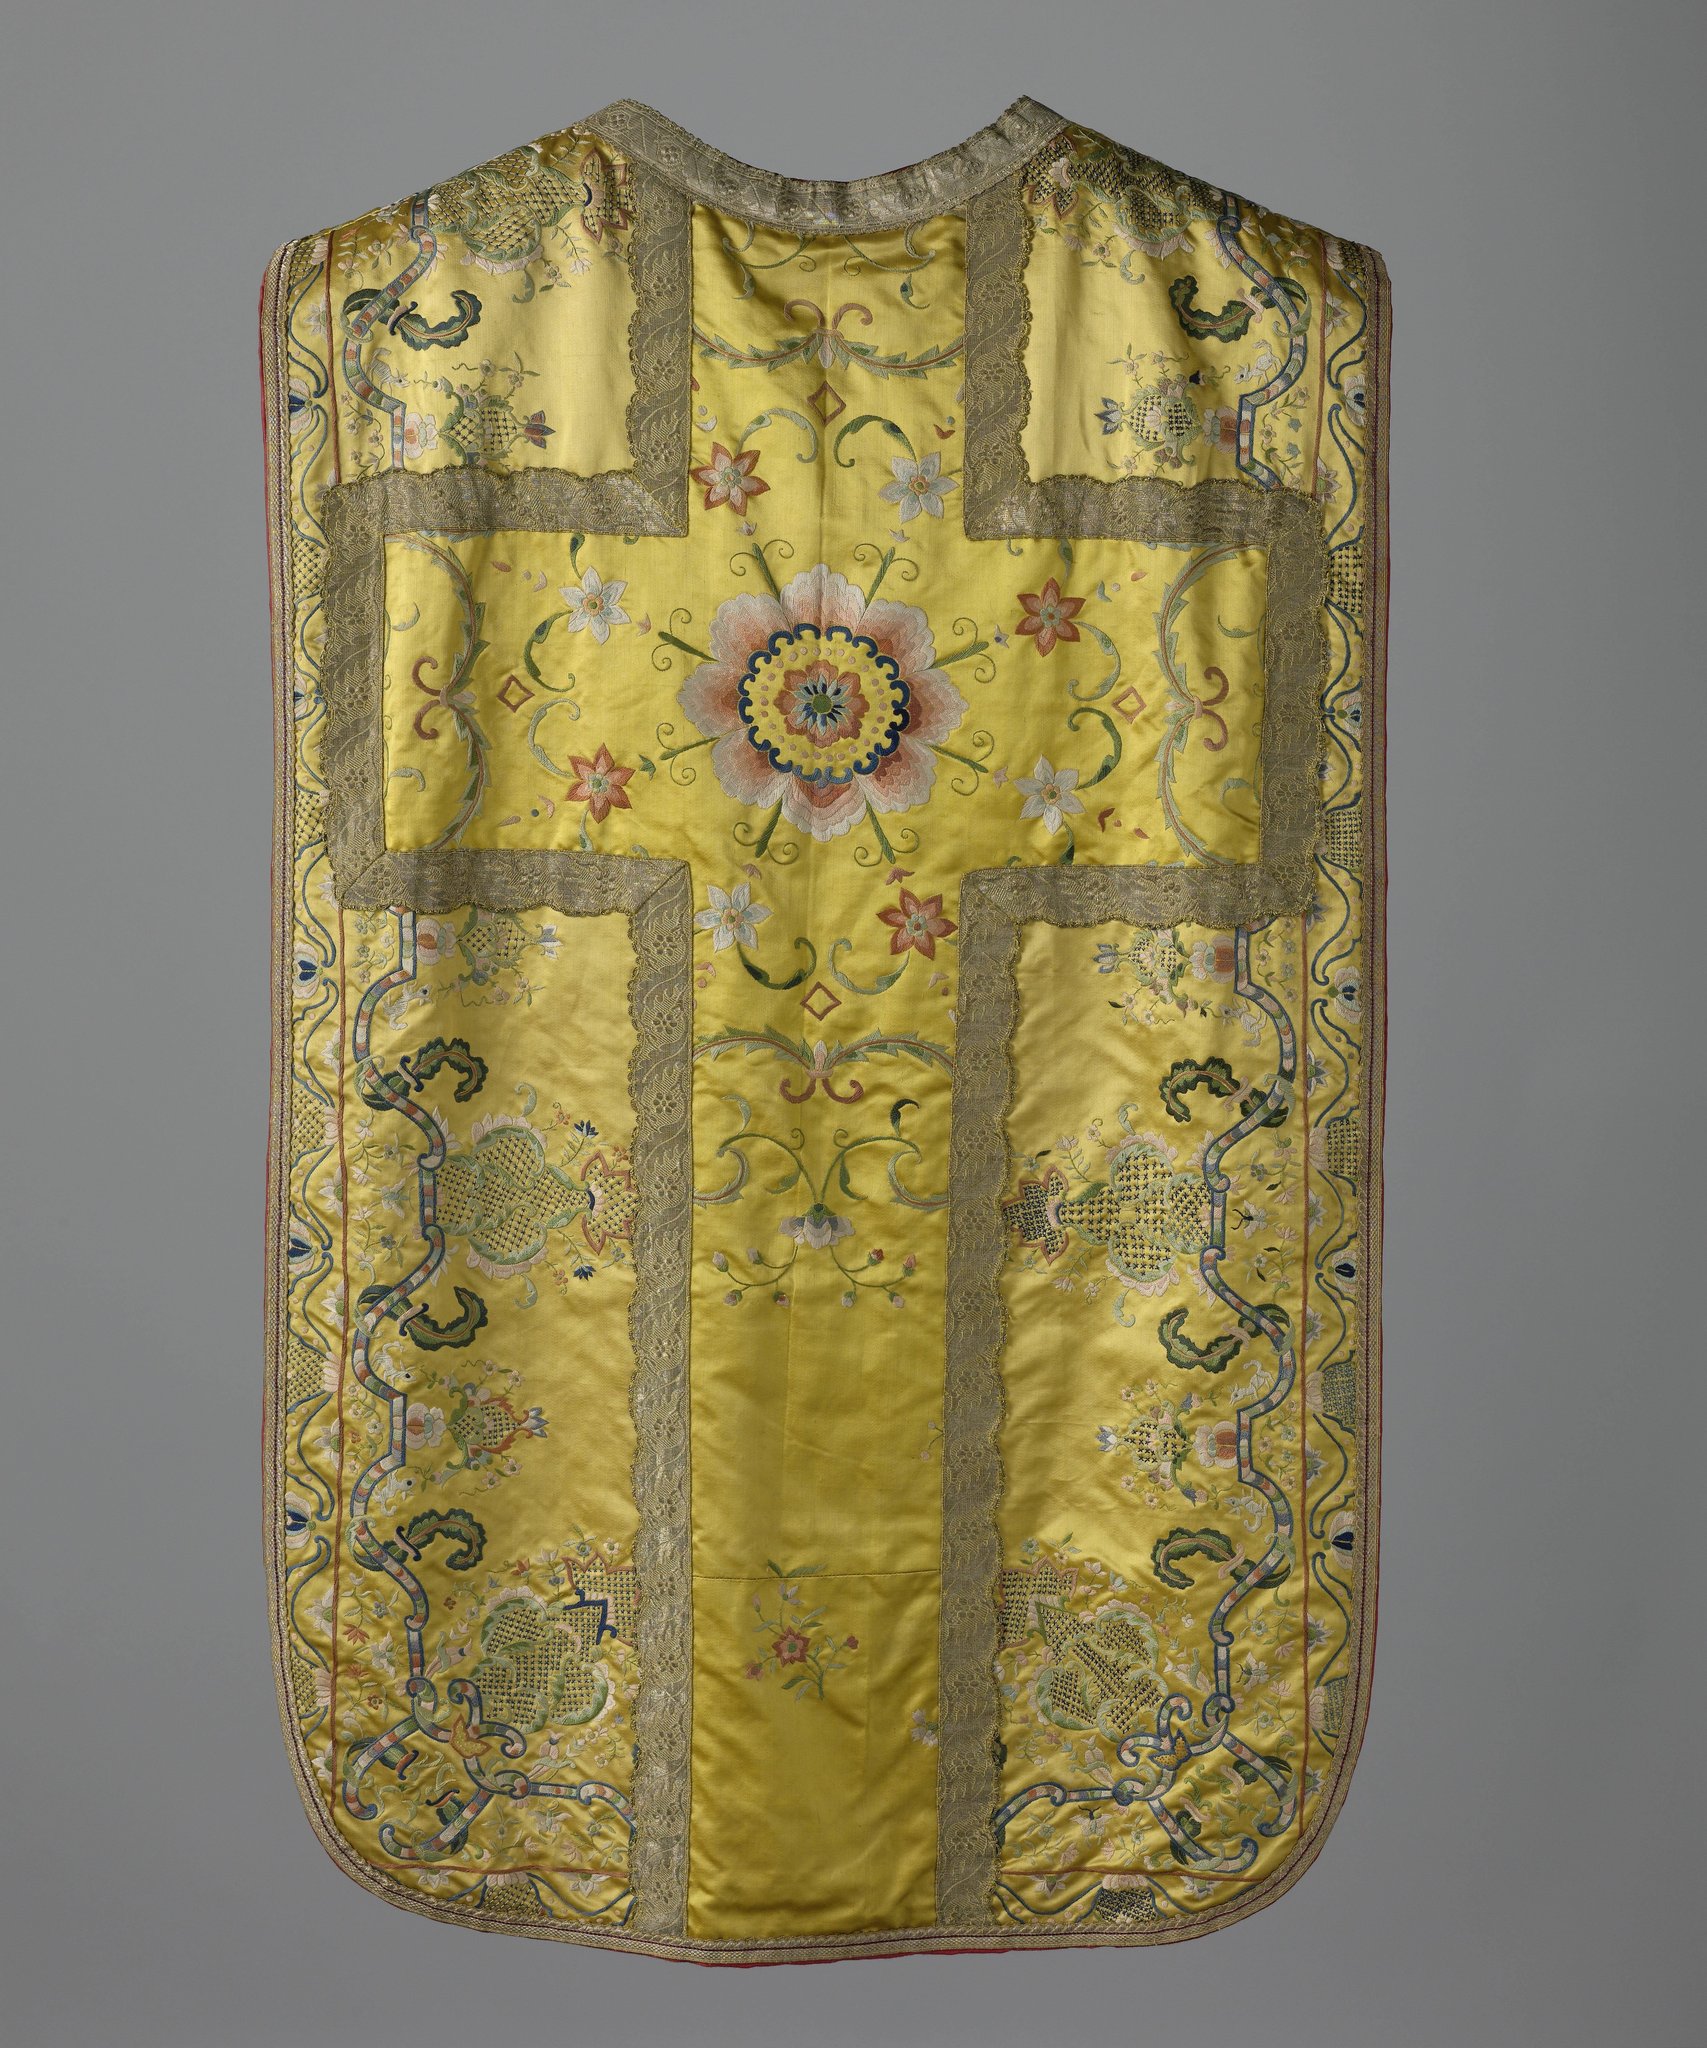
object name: chasuble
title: Kazuifel van geel zijdesatijn met borduurwerk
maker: Anonymous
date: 1750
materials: textile, silk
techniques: embroidered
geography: china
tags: st. franciscus xaveriusparochie ''t zand', amersfoort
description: Kazuifel met borduurwerk van zijde op geel zijdesatijn. De decoratie bestaat uit bloemen, ranken, bladeren, haasjes en lambrequinmotieven. Het kazuifel maakt onderdeel uit van een stel (BK-2008-176-A t/m E). Paramenten afkomstig van St. Franciscus Xaveriuskerk 't Zand te Amersfoort, volgens overlevering door Baronesse Van Stoutenburg van het slot Stoutenburg bij Amersfoort aan de kerk geschonken in de vorm van een trouwjapon en vervolgens vermaakt tot paramenten. Op grond van stofrichting en aard en richting van het ornament lijkt het eerder oorspronkelijk om tafelkleed of beddedek te gaan.